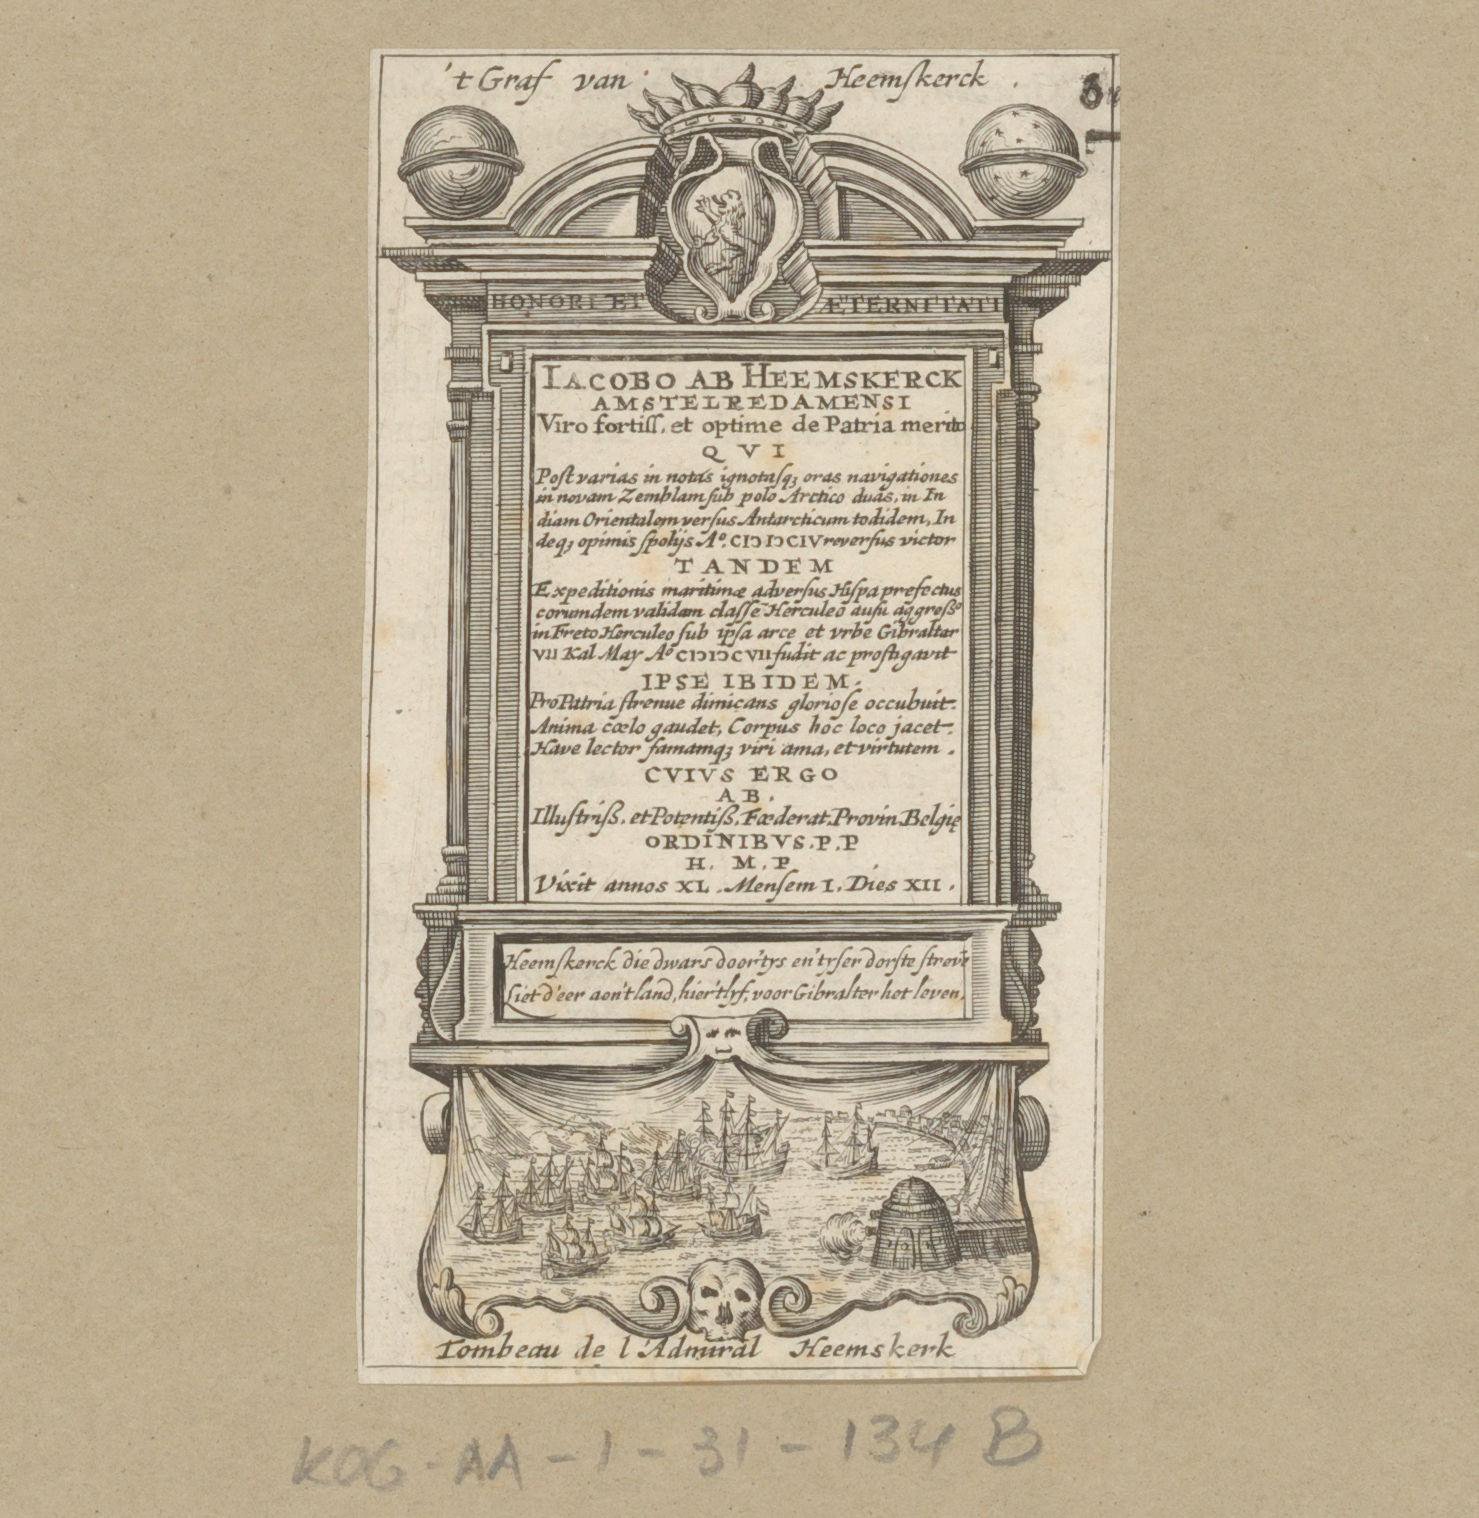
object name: book illustration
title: 't Graf van Heemskerck / Tombeau de l'Admiral Heemskerk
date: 1665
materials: ink, paper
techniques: engraving, etching, letterpress printing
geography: northern netherlands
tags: jacob van heemskerck, battle (+ naval force), grave-building, monumental tomb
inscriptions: inscription: ‘Uit: Domselaer, Amsterdam. 1665. 4e bladz. 54 en 55’, collector's mark: ‘31.134A/B’ Lugt 1641b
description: Gesneuveld tijdens de zeeslag tussen de Staatse en Spaanse vloten in de baai van Gibraltar op 25 april 1607 en begraven op 8 juni 1607. Onderaan een voorstelling van de zeeslag bij Gibraltar. Onderwerpsrubriek binnen de Atlas Amsterdam: Kerkwezen: Hervormde Gemeente: Oude Kerk van binnen.